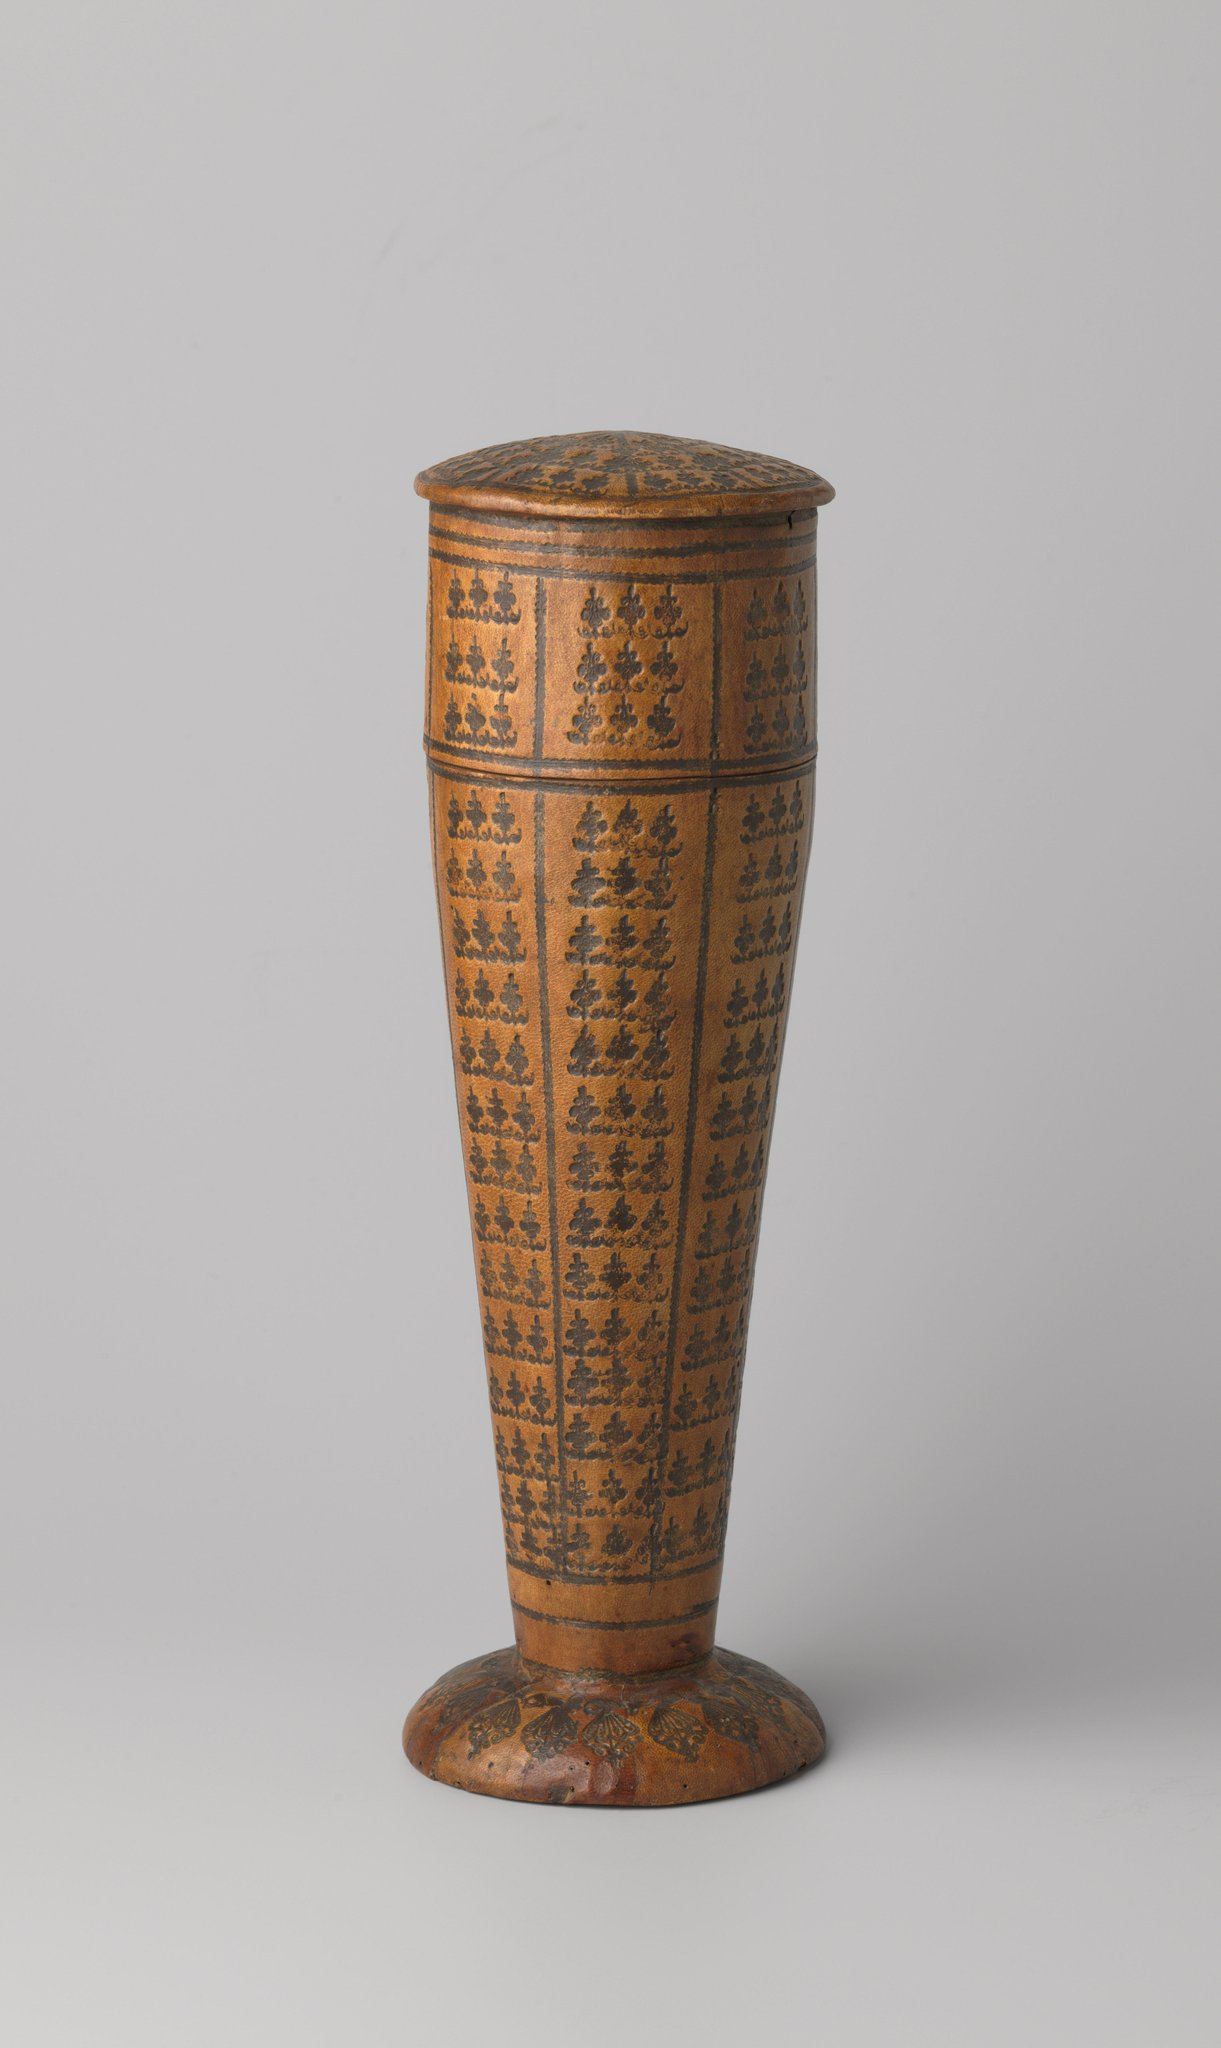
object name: case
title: Foedraal met eenvoudige boomversiering in rijen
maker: Anonymous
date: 1700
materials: cardboard, leather, wood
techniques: cutting, printing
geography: netherlands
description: Een houten, slank canopische foedraal, van binnen met karton en van buiten met leer beplakt, aan de buitenzijde bewerkt met eenvoudige boomversiering in rijen van drie gegroepeerd. De omgekeerd schotelvormige voet is rondom bewerkt met in het leer gedrukte medaillons. Aan de binnenzijde 12 vakken, van elkaar gescheiden door een kartonnen raster. De cilindrische deksel sluit over de schacht.